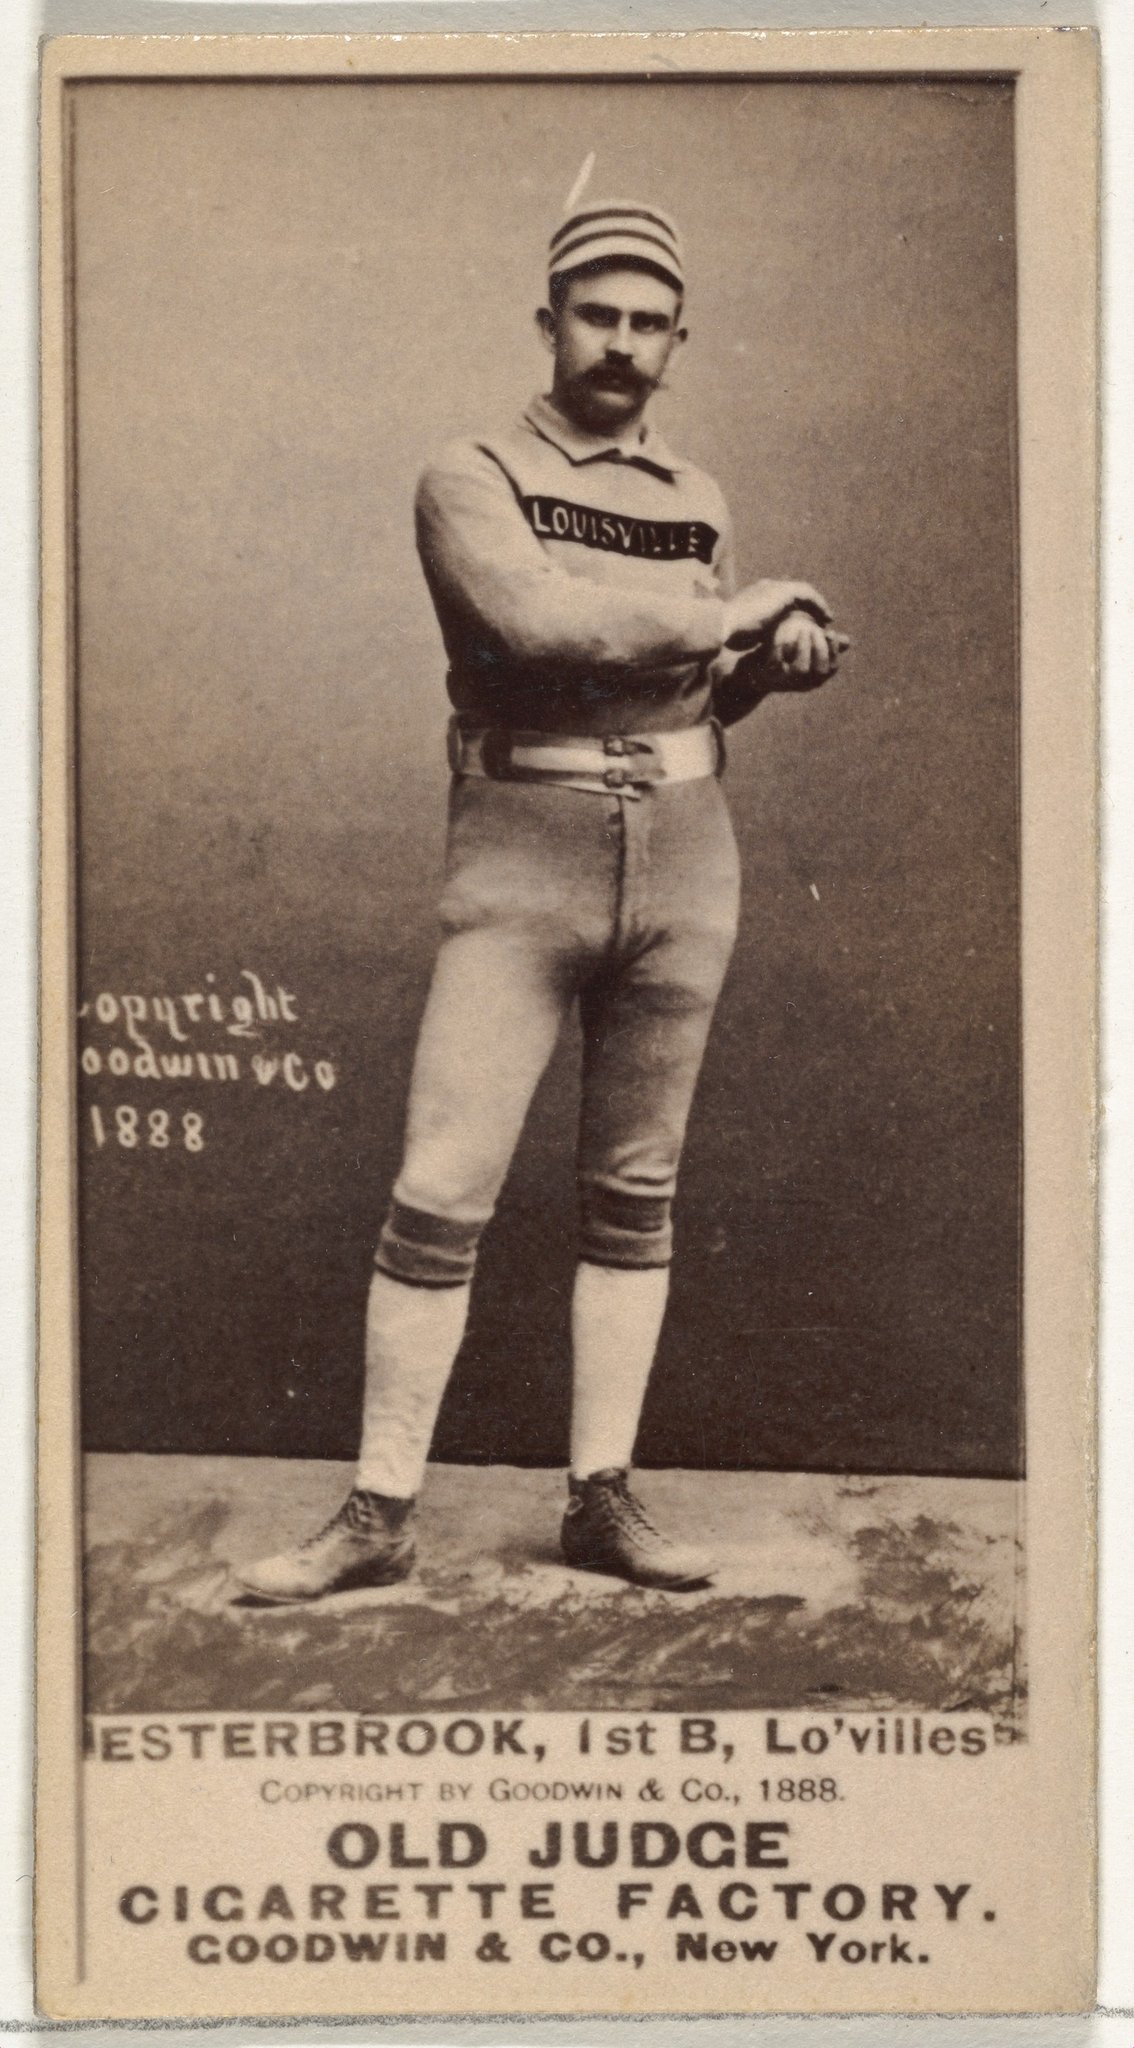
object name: baseball card, photograph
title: Thomas John "Dude" Esterbrook, 1st Base, Louisville Colonels, from the Old Judge series (N172) for Old Judge Cigarettes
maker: goodwin & company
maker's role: publisher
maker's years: 1850-1950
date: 1888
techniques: albumen silver print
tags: men,portraits,baseball,athletes